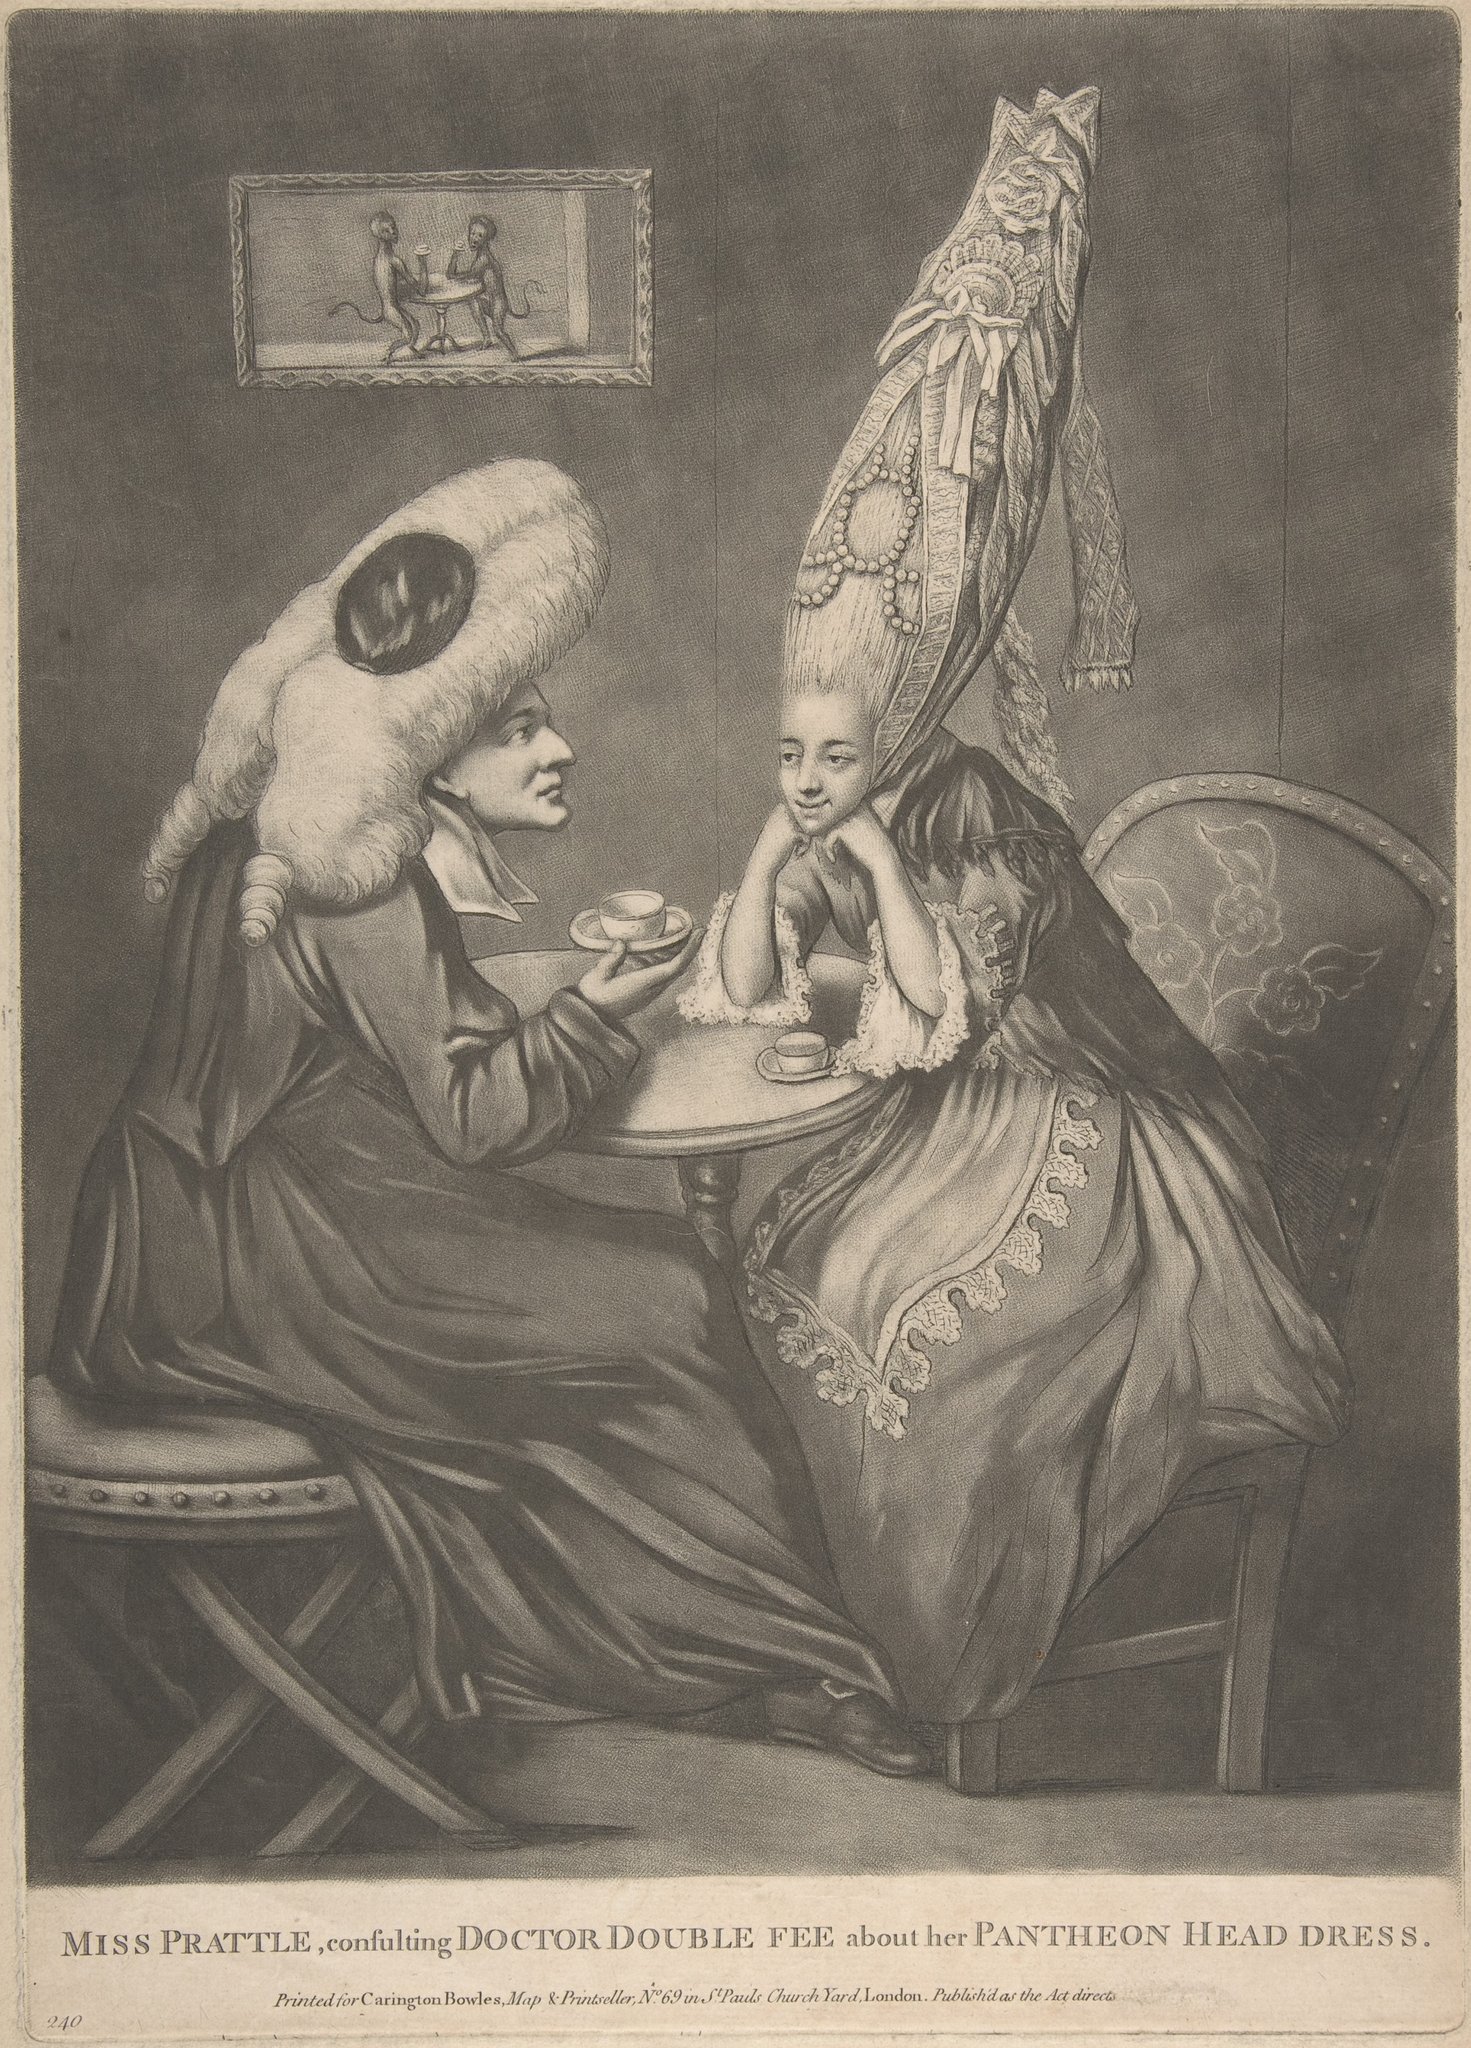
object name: print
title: Miss Prattle Consulting Doctor Double Fee about her Pantheon Head Dress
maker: anonymous, british, 18th century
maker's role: artist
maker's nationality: british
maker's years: 1700-1800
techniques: mezzotint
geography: london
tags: satire,men,women,caricature,wigs